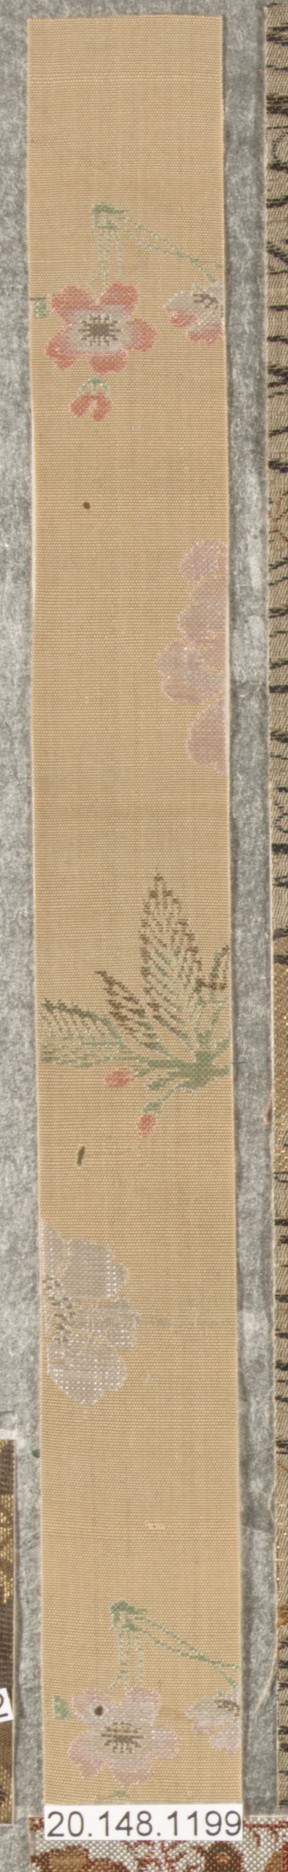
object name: piece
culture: japanese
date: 1701-1800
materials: silk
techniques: compound weave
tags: flowers,leaves